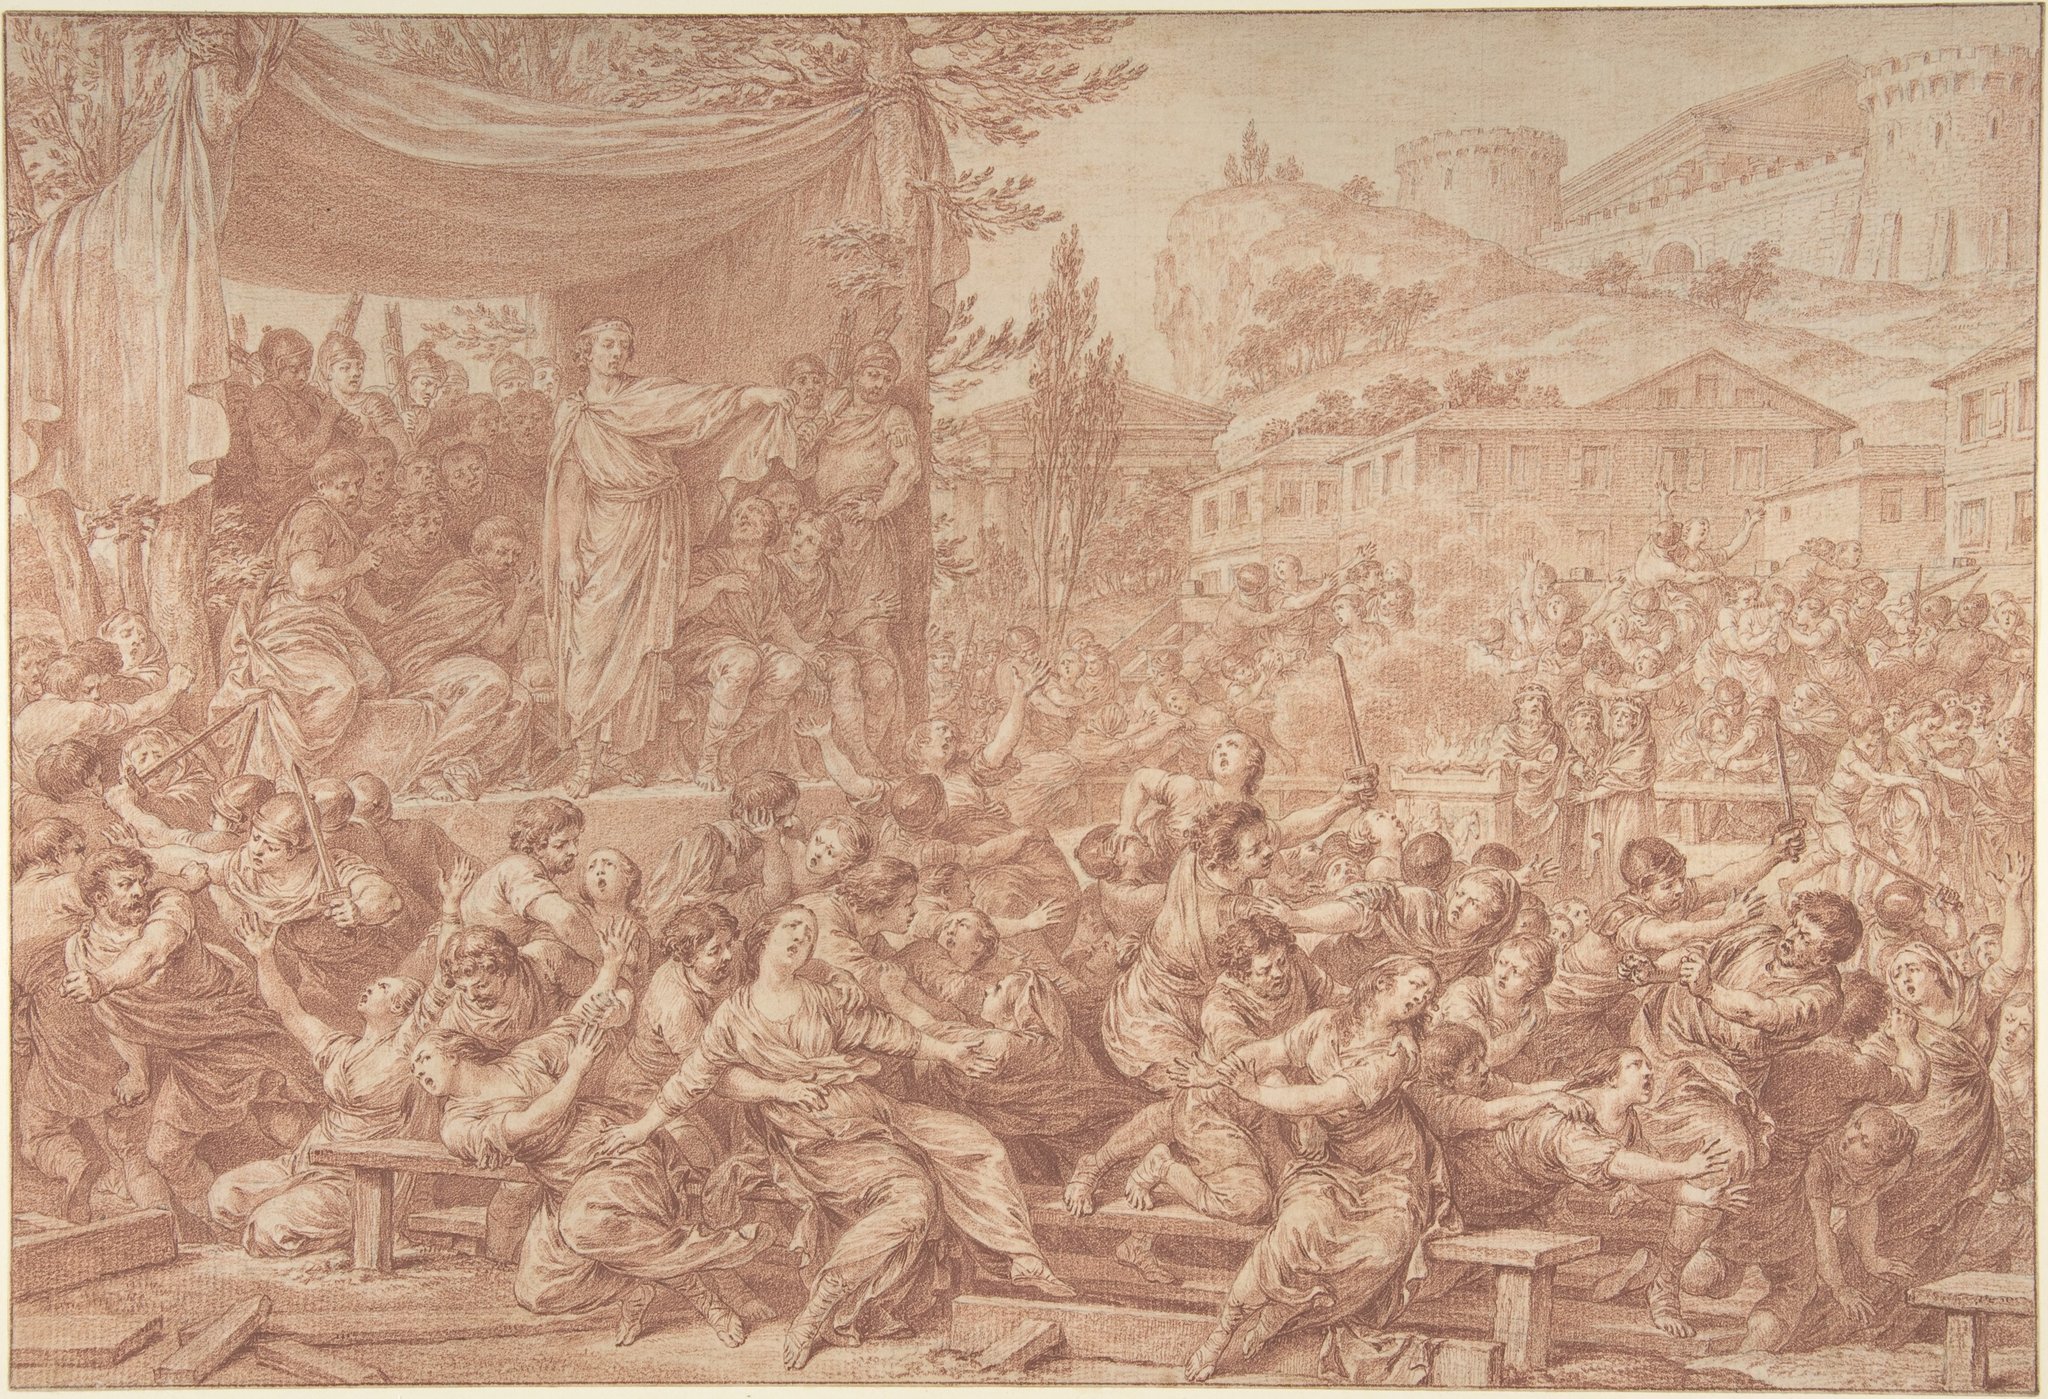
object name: drawing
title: The Rape of the Sabine Women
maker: charles nicolas cochin ii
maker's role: artist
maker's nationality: french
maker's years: 1715-1790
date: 1781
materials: chalk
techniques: drawing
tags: men,women